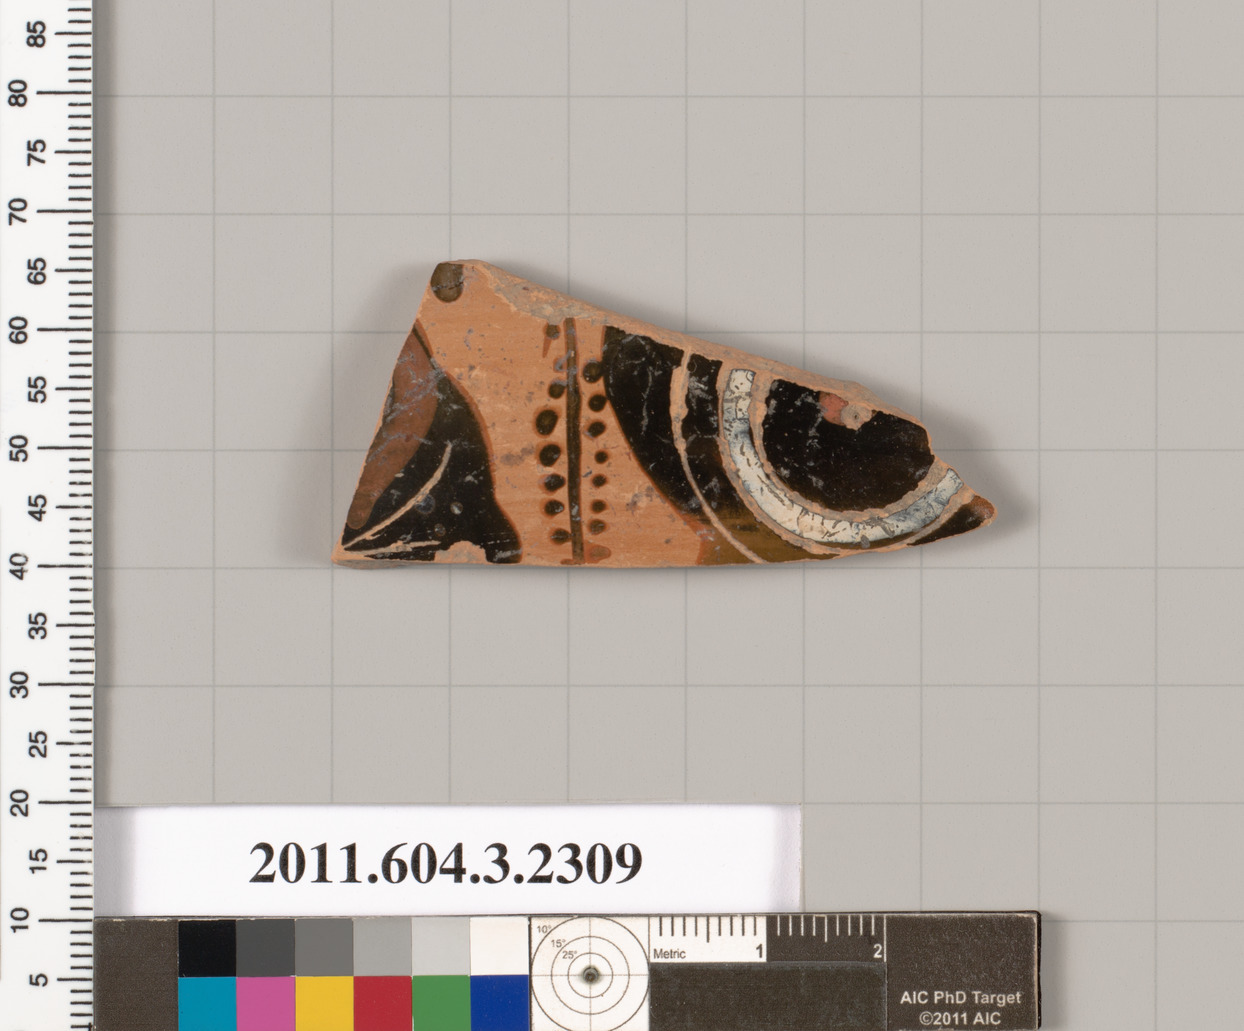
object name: kylix fragment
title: Terracotta fragment of a kylix: eye-cup (drinking cup)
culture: greek, attic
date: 530-510 BCE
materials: terracotta